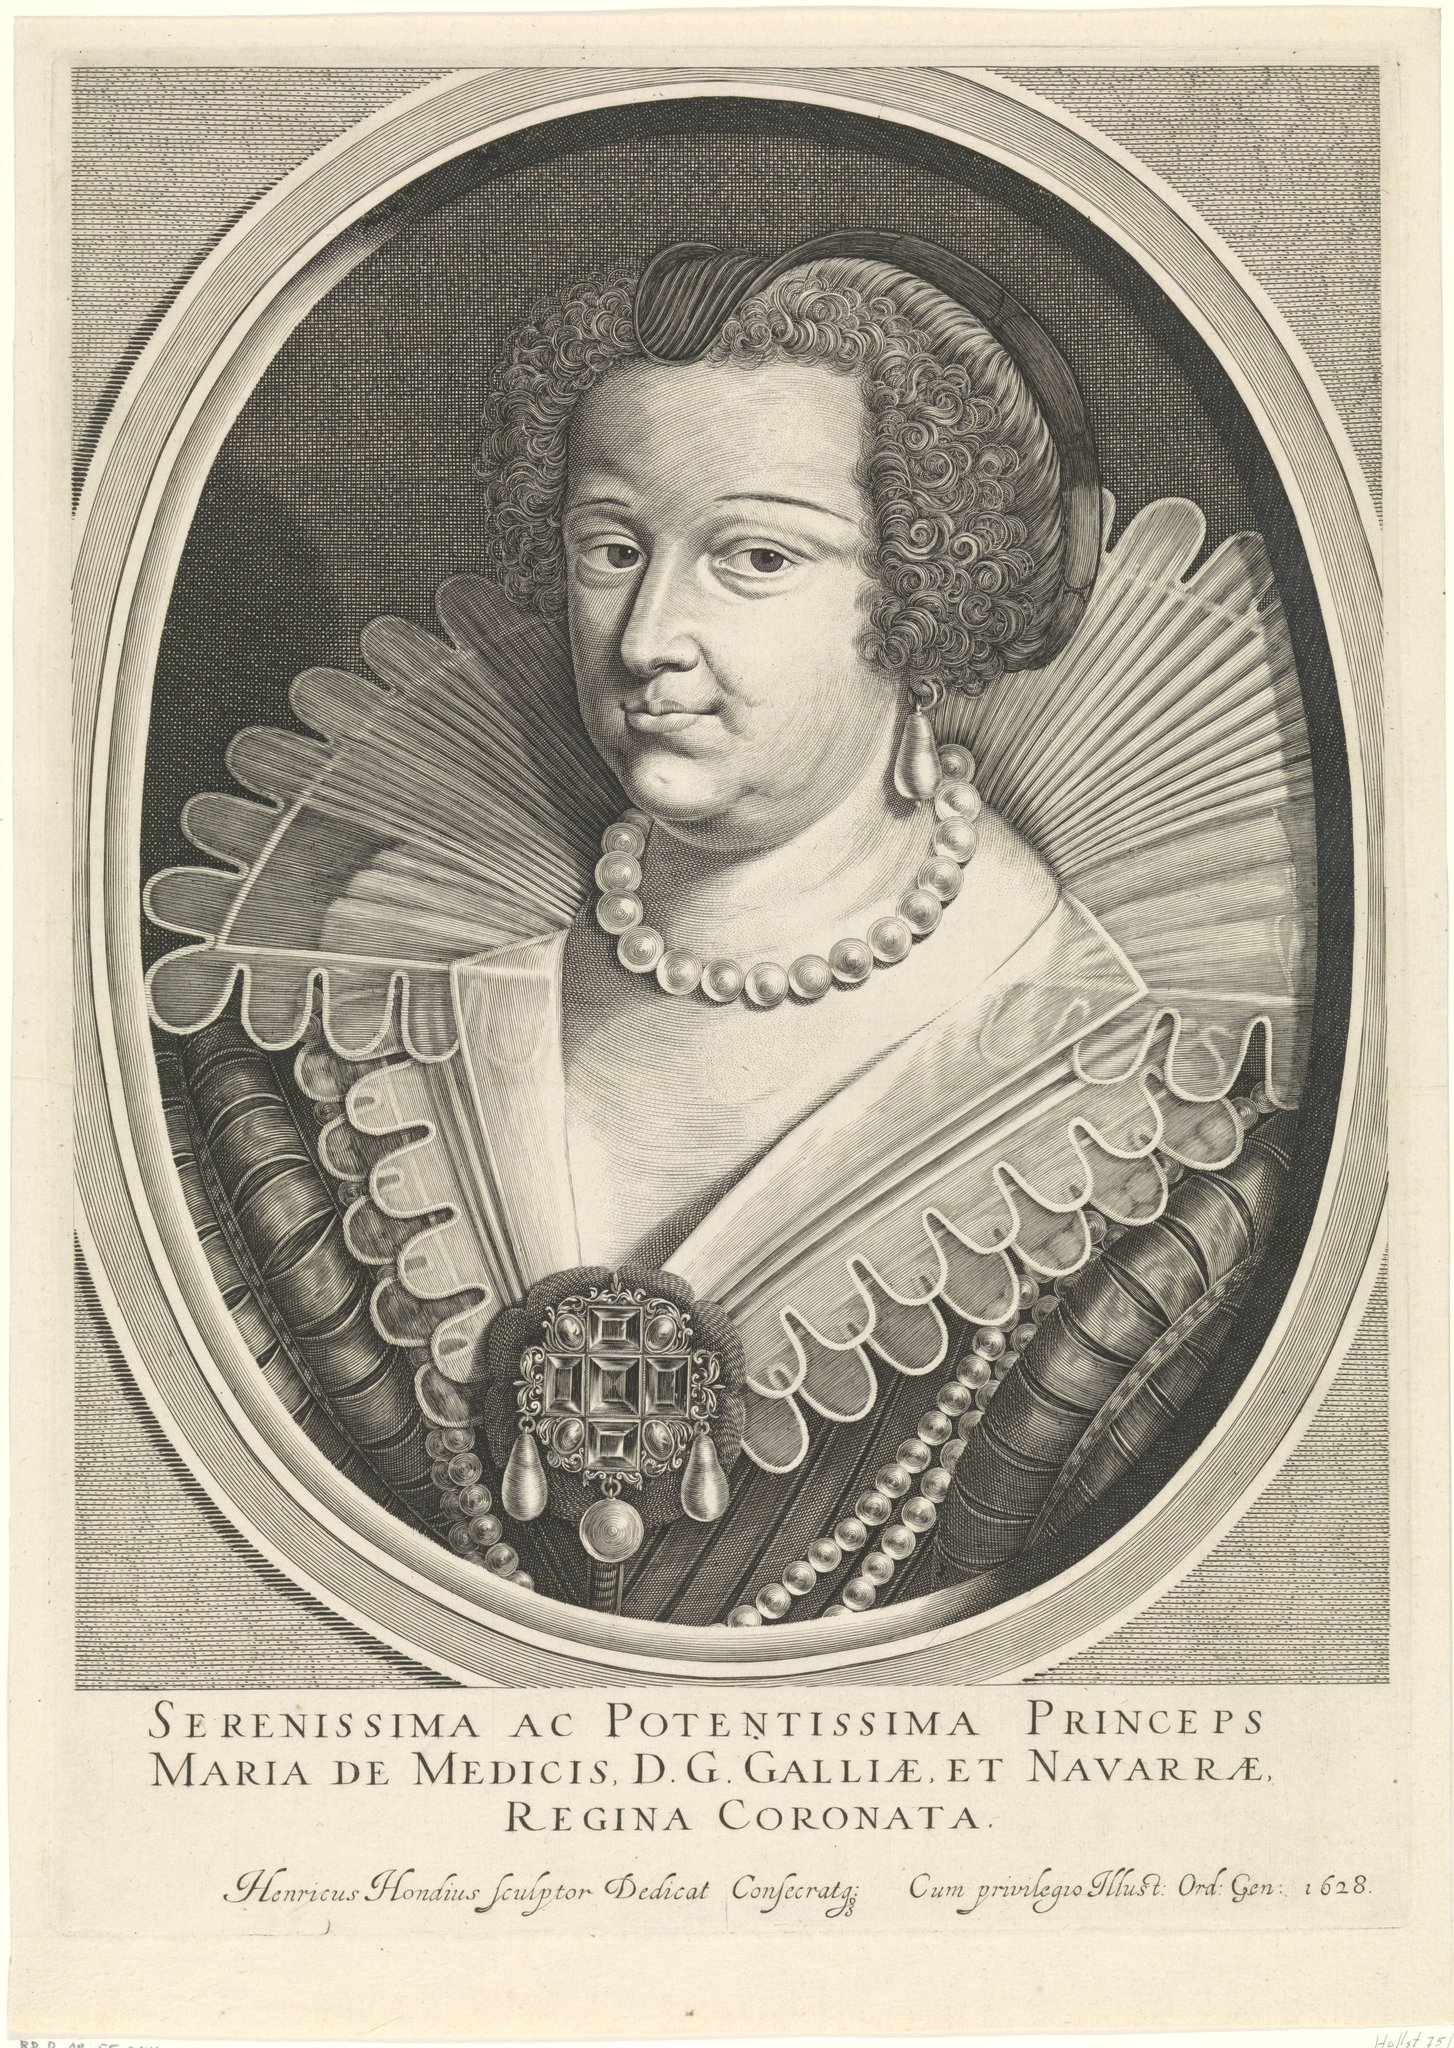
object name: print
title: Portret van Maria de' Medici, koningin van Frankrijk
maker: hendrick hondius (i)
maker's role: draughtsman, print maker, publisher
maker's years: 1573-1650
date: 1628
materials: paper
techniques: engraving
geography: the hague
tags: cologne, print maker, maria de' medici, ear-rings (+ women's clothes), brooch, agraffe, clasp (+ women's clothes), neck-gear: collar (+ lace used for clothes), pearl; pearl necklace (+ women's clothes)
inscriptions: collector's mark: Lugt 2228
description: Buste naar links van Maria de' Medici, koningin van Frankrijk in een ovale omlijsting. Onder het portret drie regels in het Latijn.